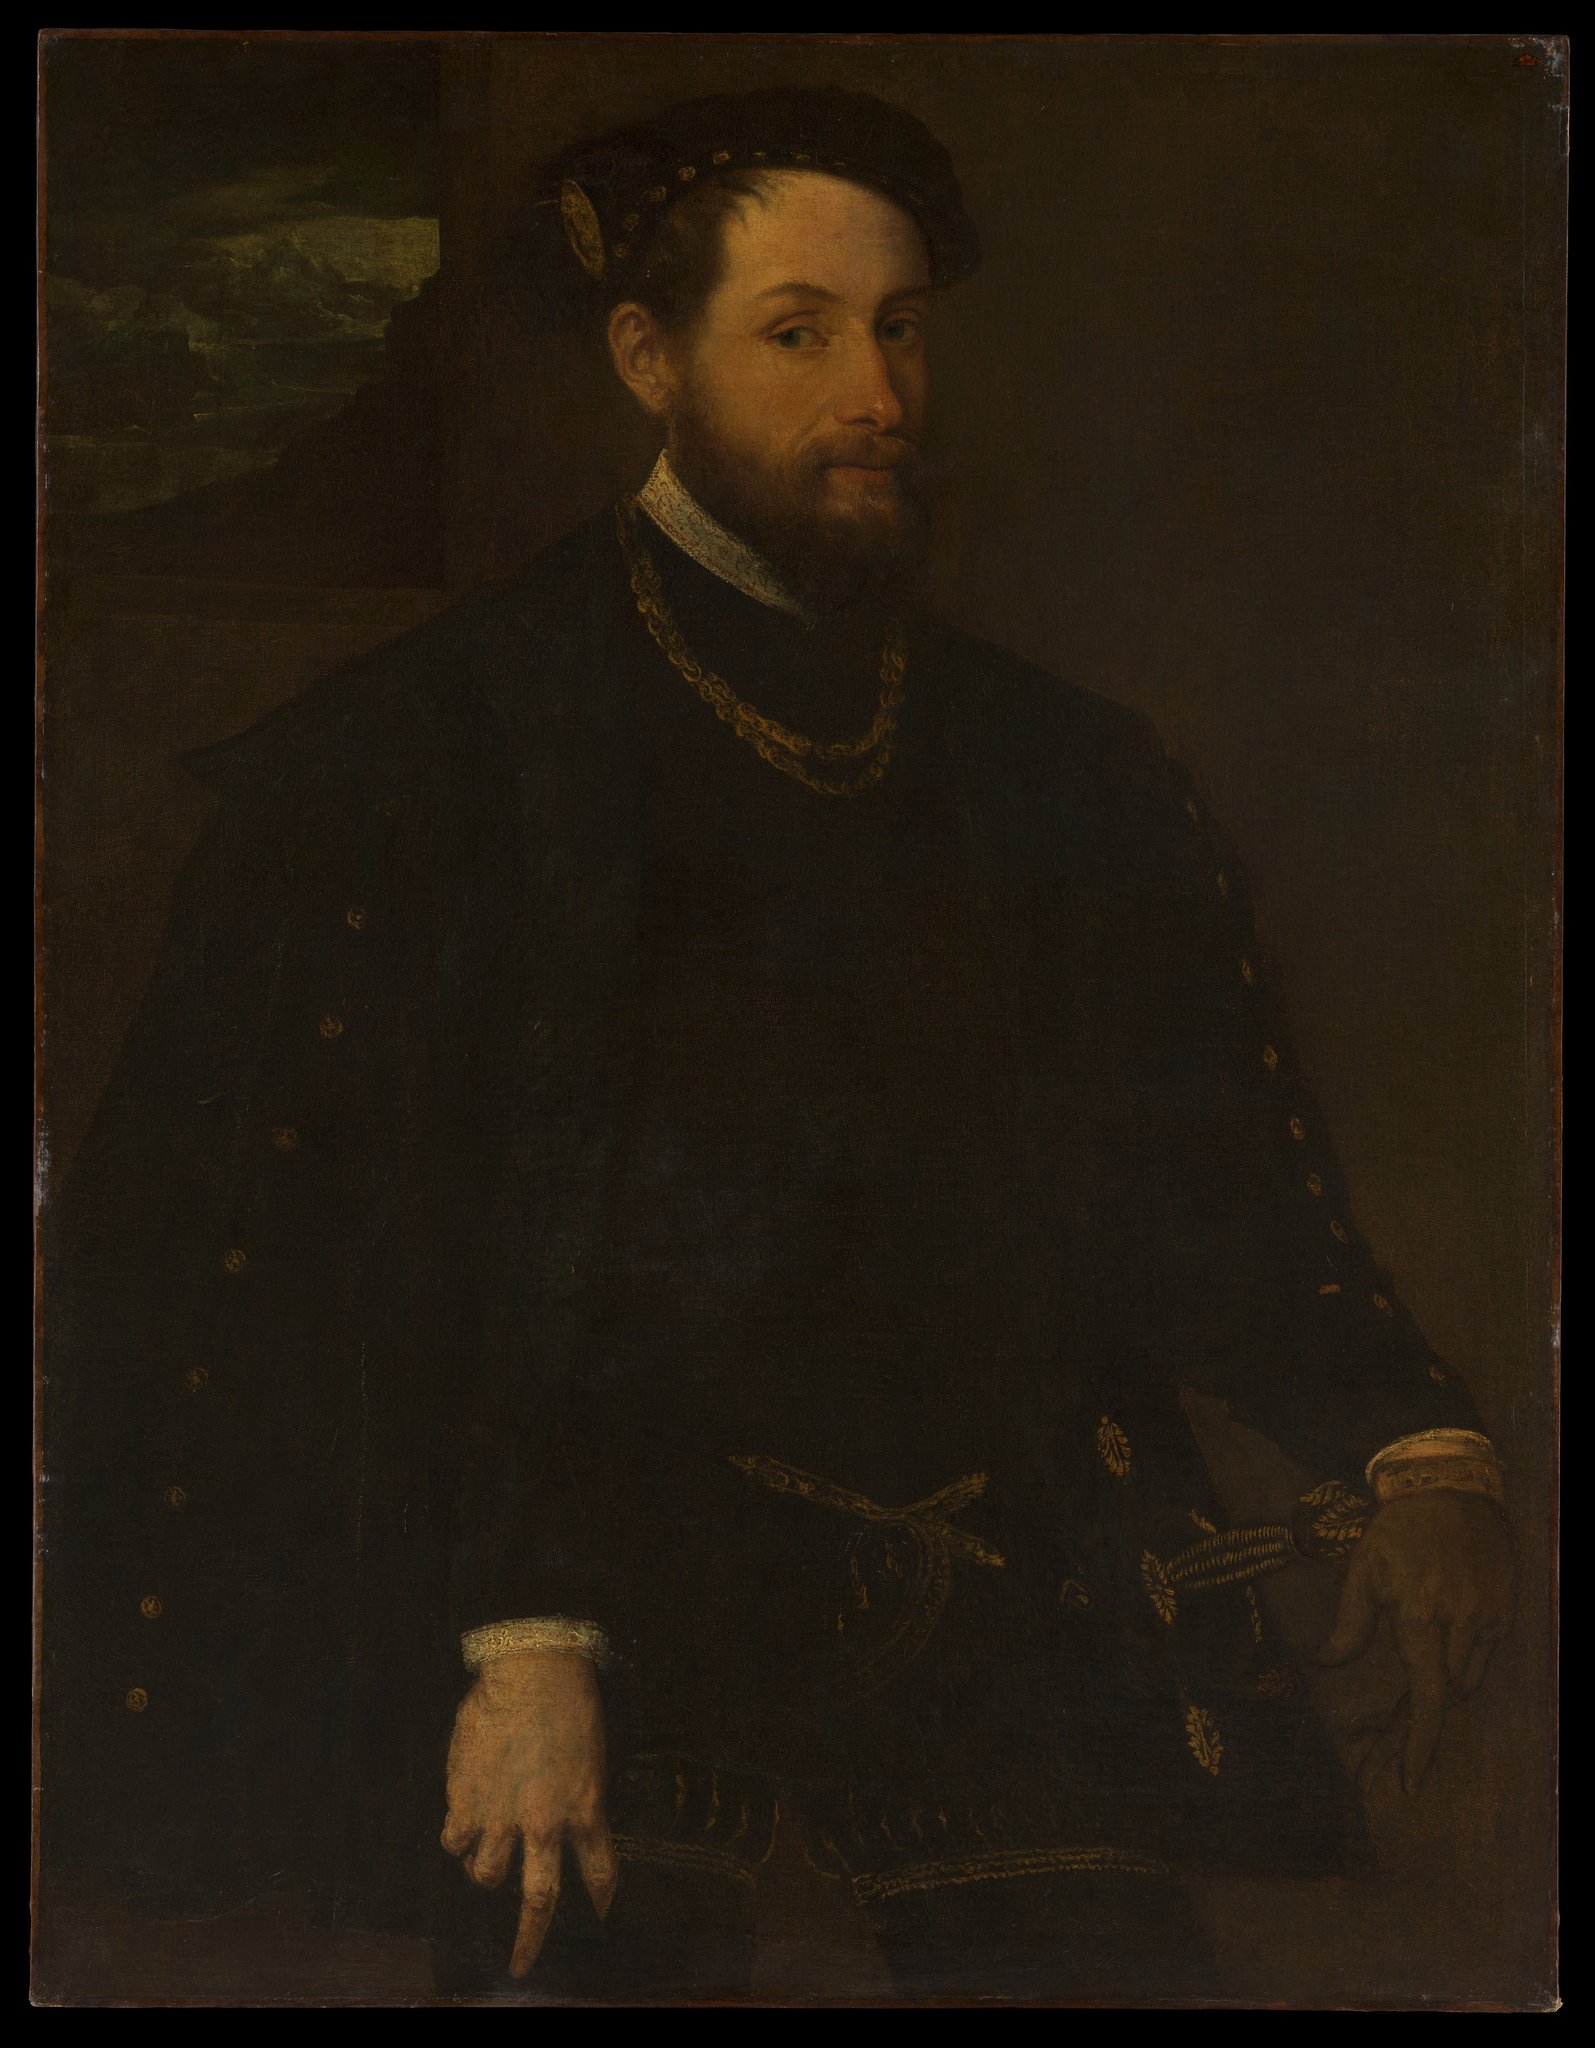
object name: painting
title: Portrait of a Man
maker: lambert sustris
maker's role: artist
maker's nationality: netherlandish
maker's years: 1510-1560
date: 1535-1568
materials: canvas, oil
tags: men,portraits